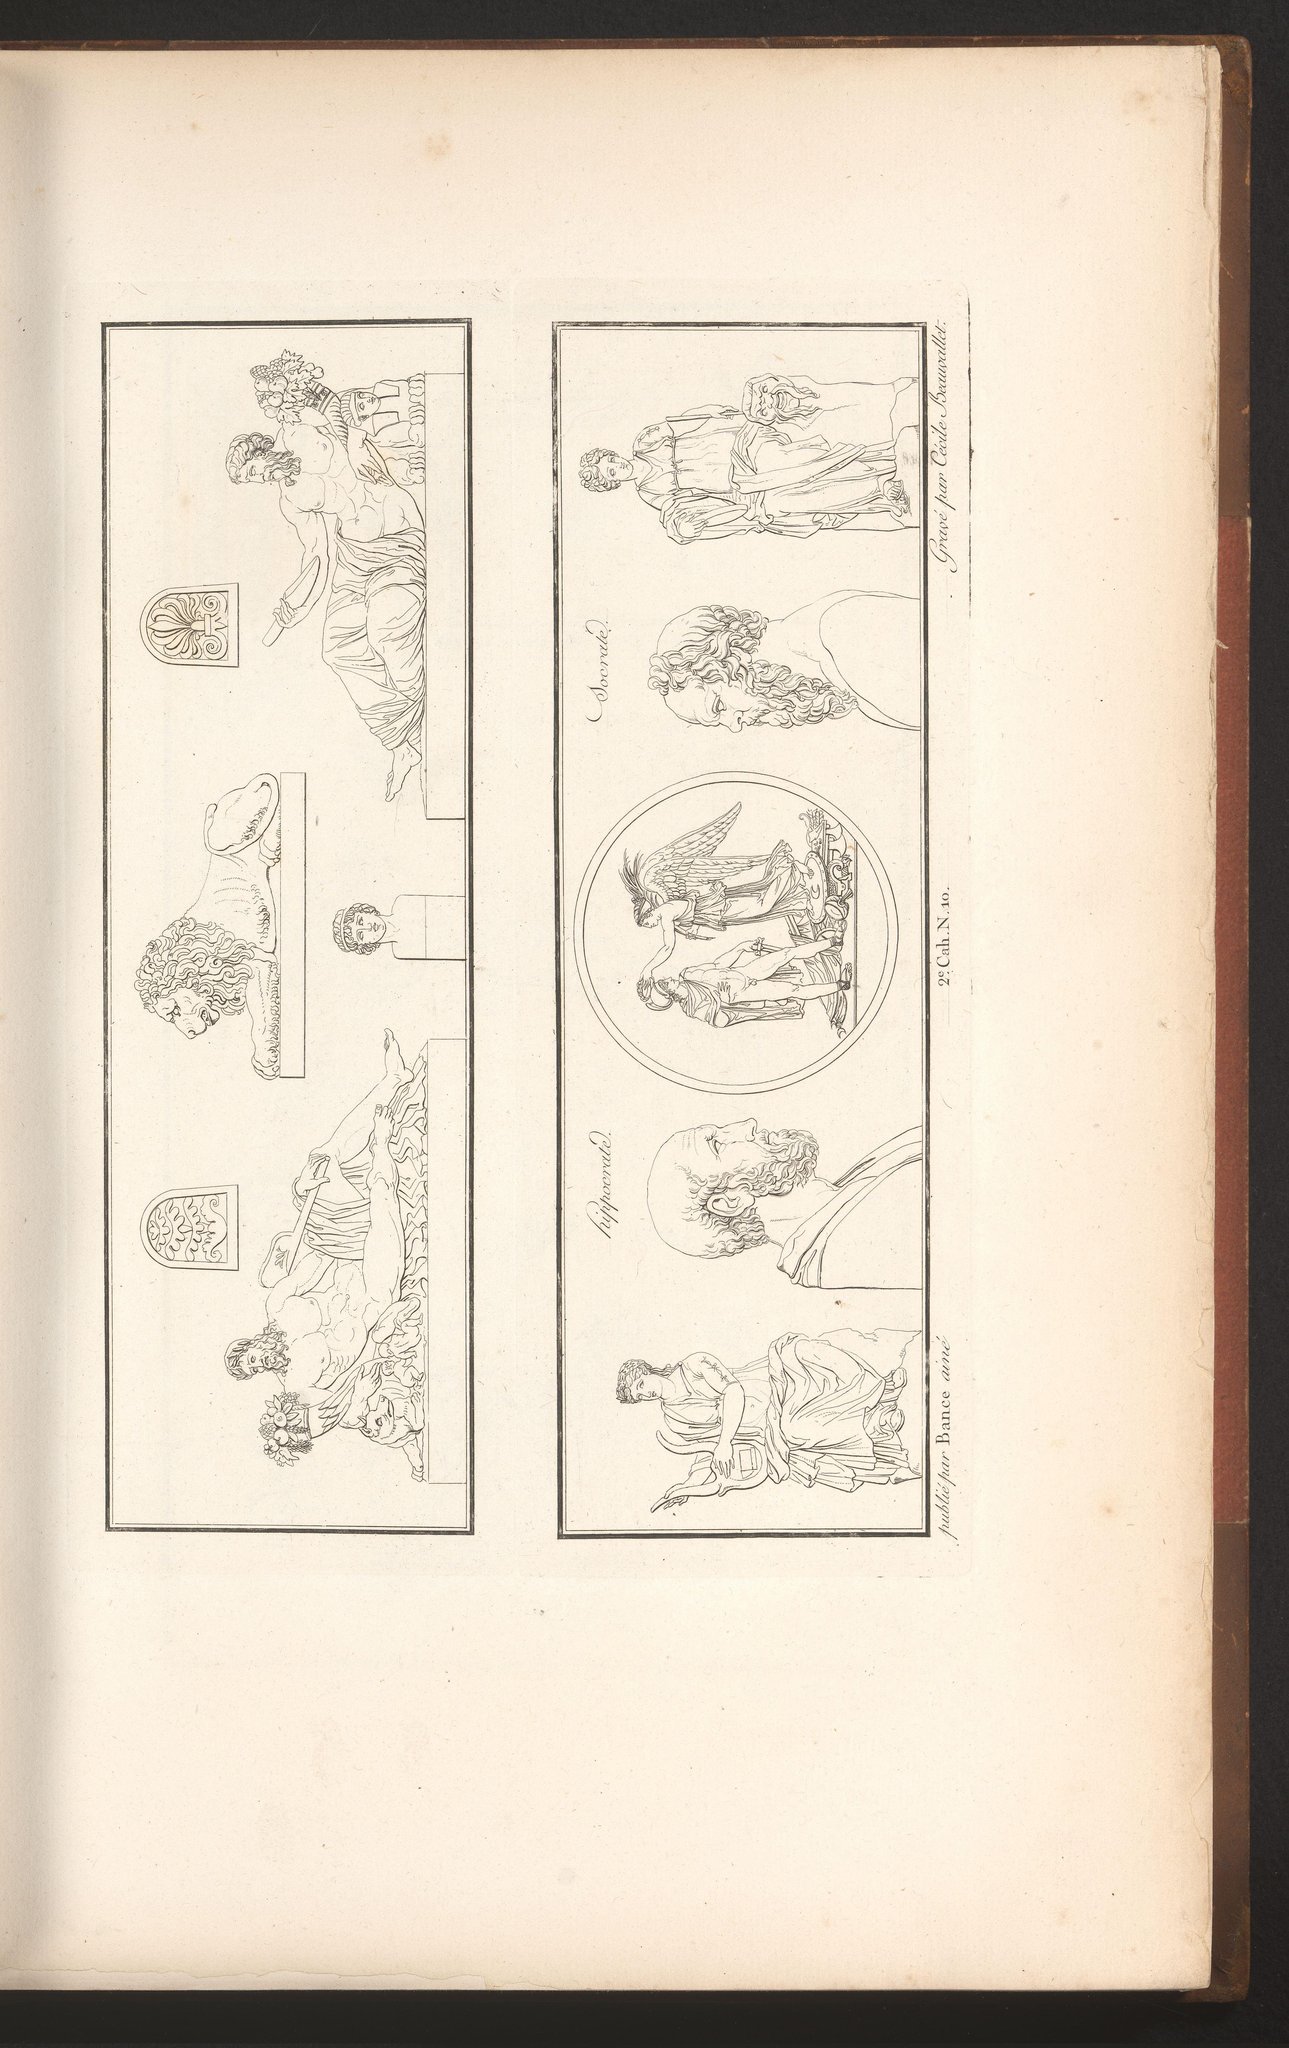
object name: ornament print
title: Twee voorstellingen met meerdere figuren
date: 1820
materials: paper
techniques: etching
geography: paris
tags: ornaments ~ art, historical persons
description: Ornamentprent met twee voorstellingen met meerdere figuren, onderaan o.a. Hippocrates en Socrates. Onderdeel (2e. Cah. N. 10) van het prentalbum met twee series van in totaal 138 ornamentprenten door Beauvallet en Normand, 'Fragmens d'Ornemens dans le Style Antique'.